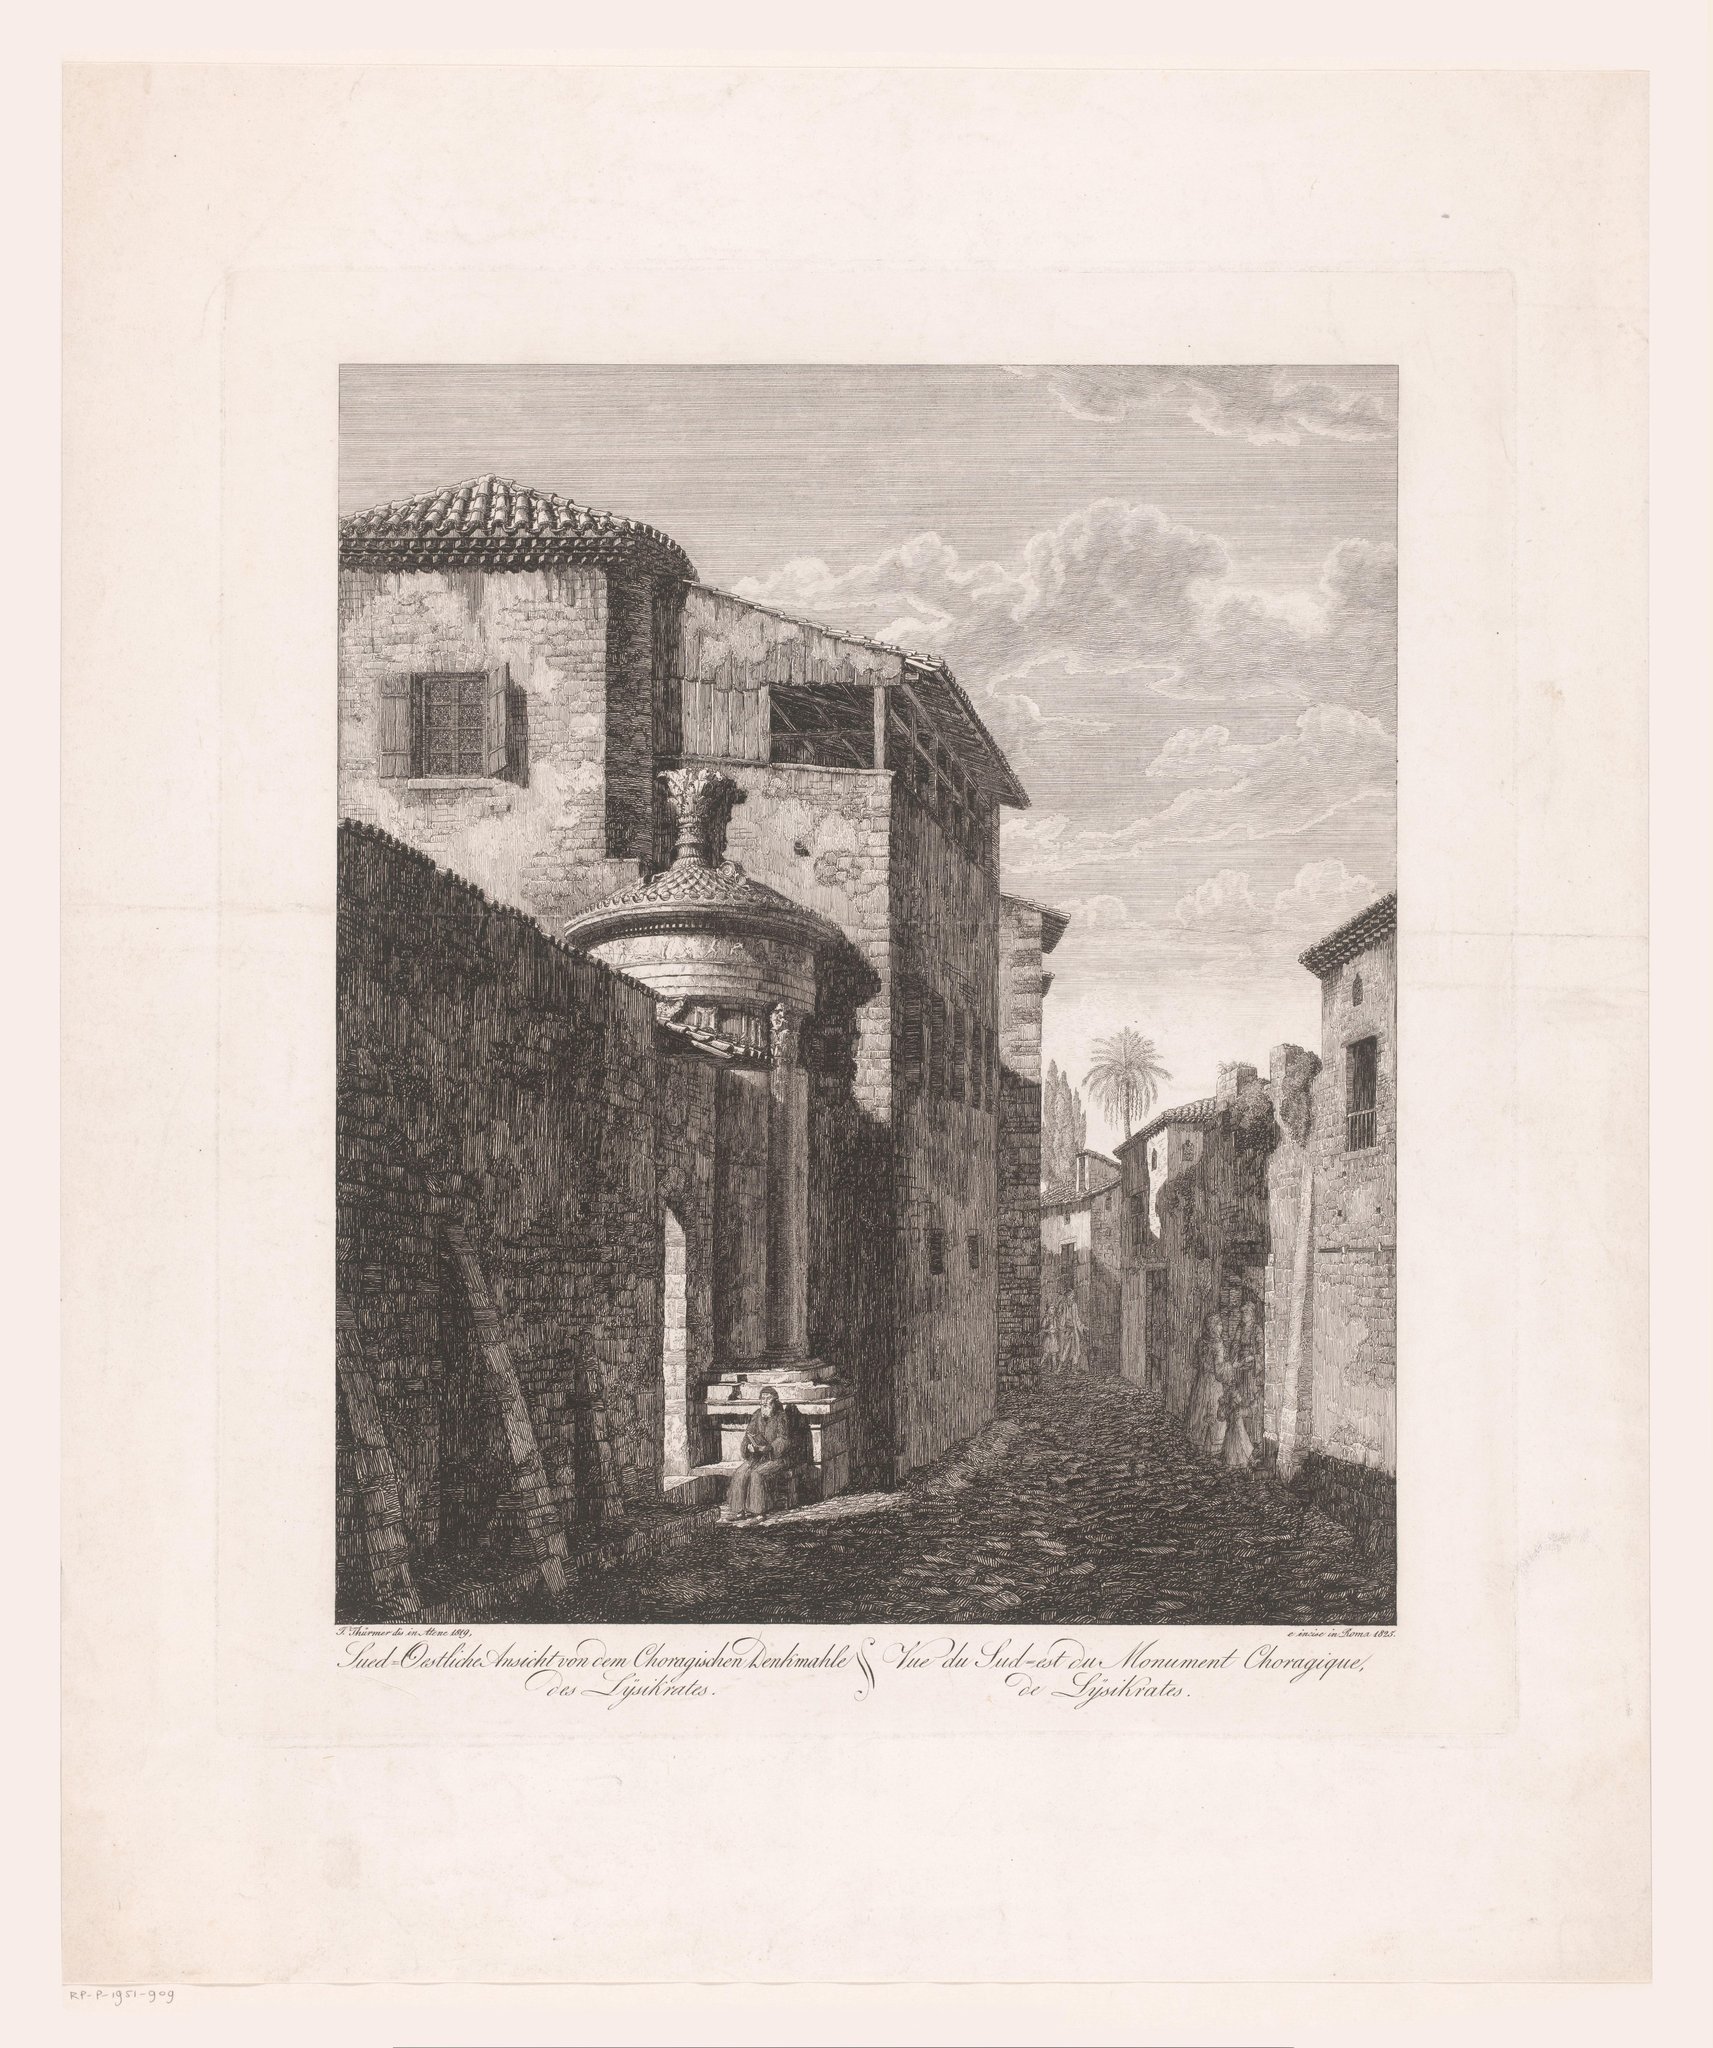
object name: print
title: Straat in Athene met het choregisch monument van Lysicrates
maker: joseph thürmer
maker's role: print maker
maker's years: 1789-1833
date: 1825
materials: paper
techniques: etching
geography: rome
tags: city-view in general; 'veduta', monument, statue, street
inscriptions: collector's mark: Lugt 2228